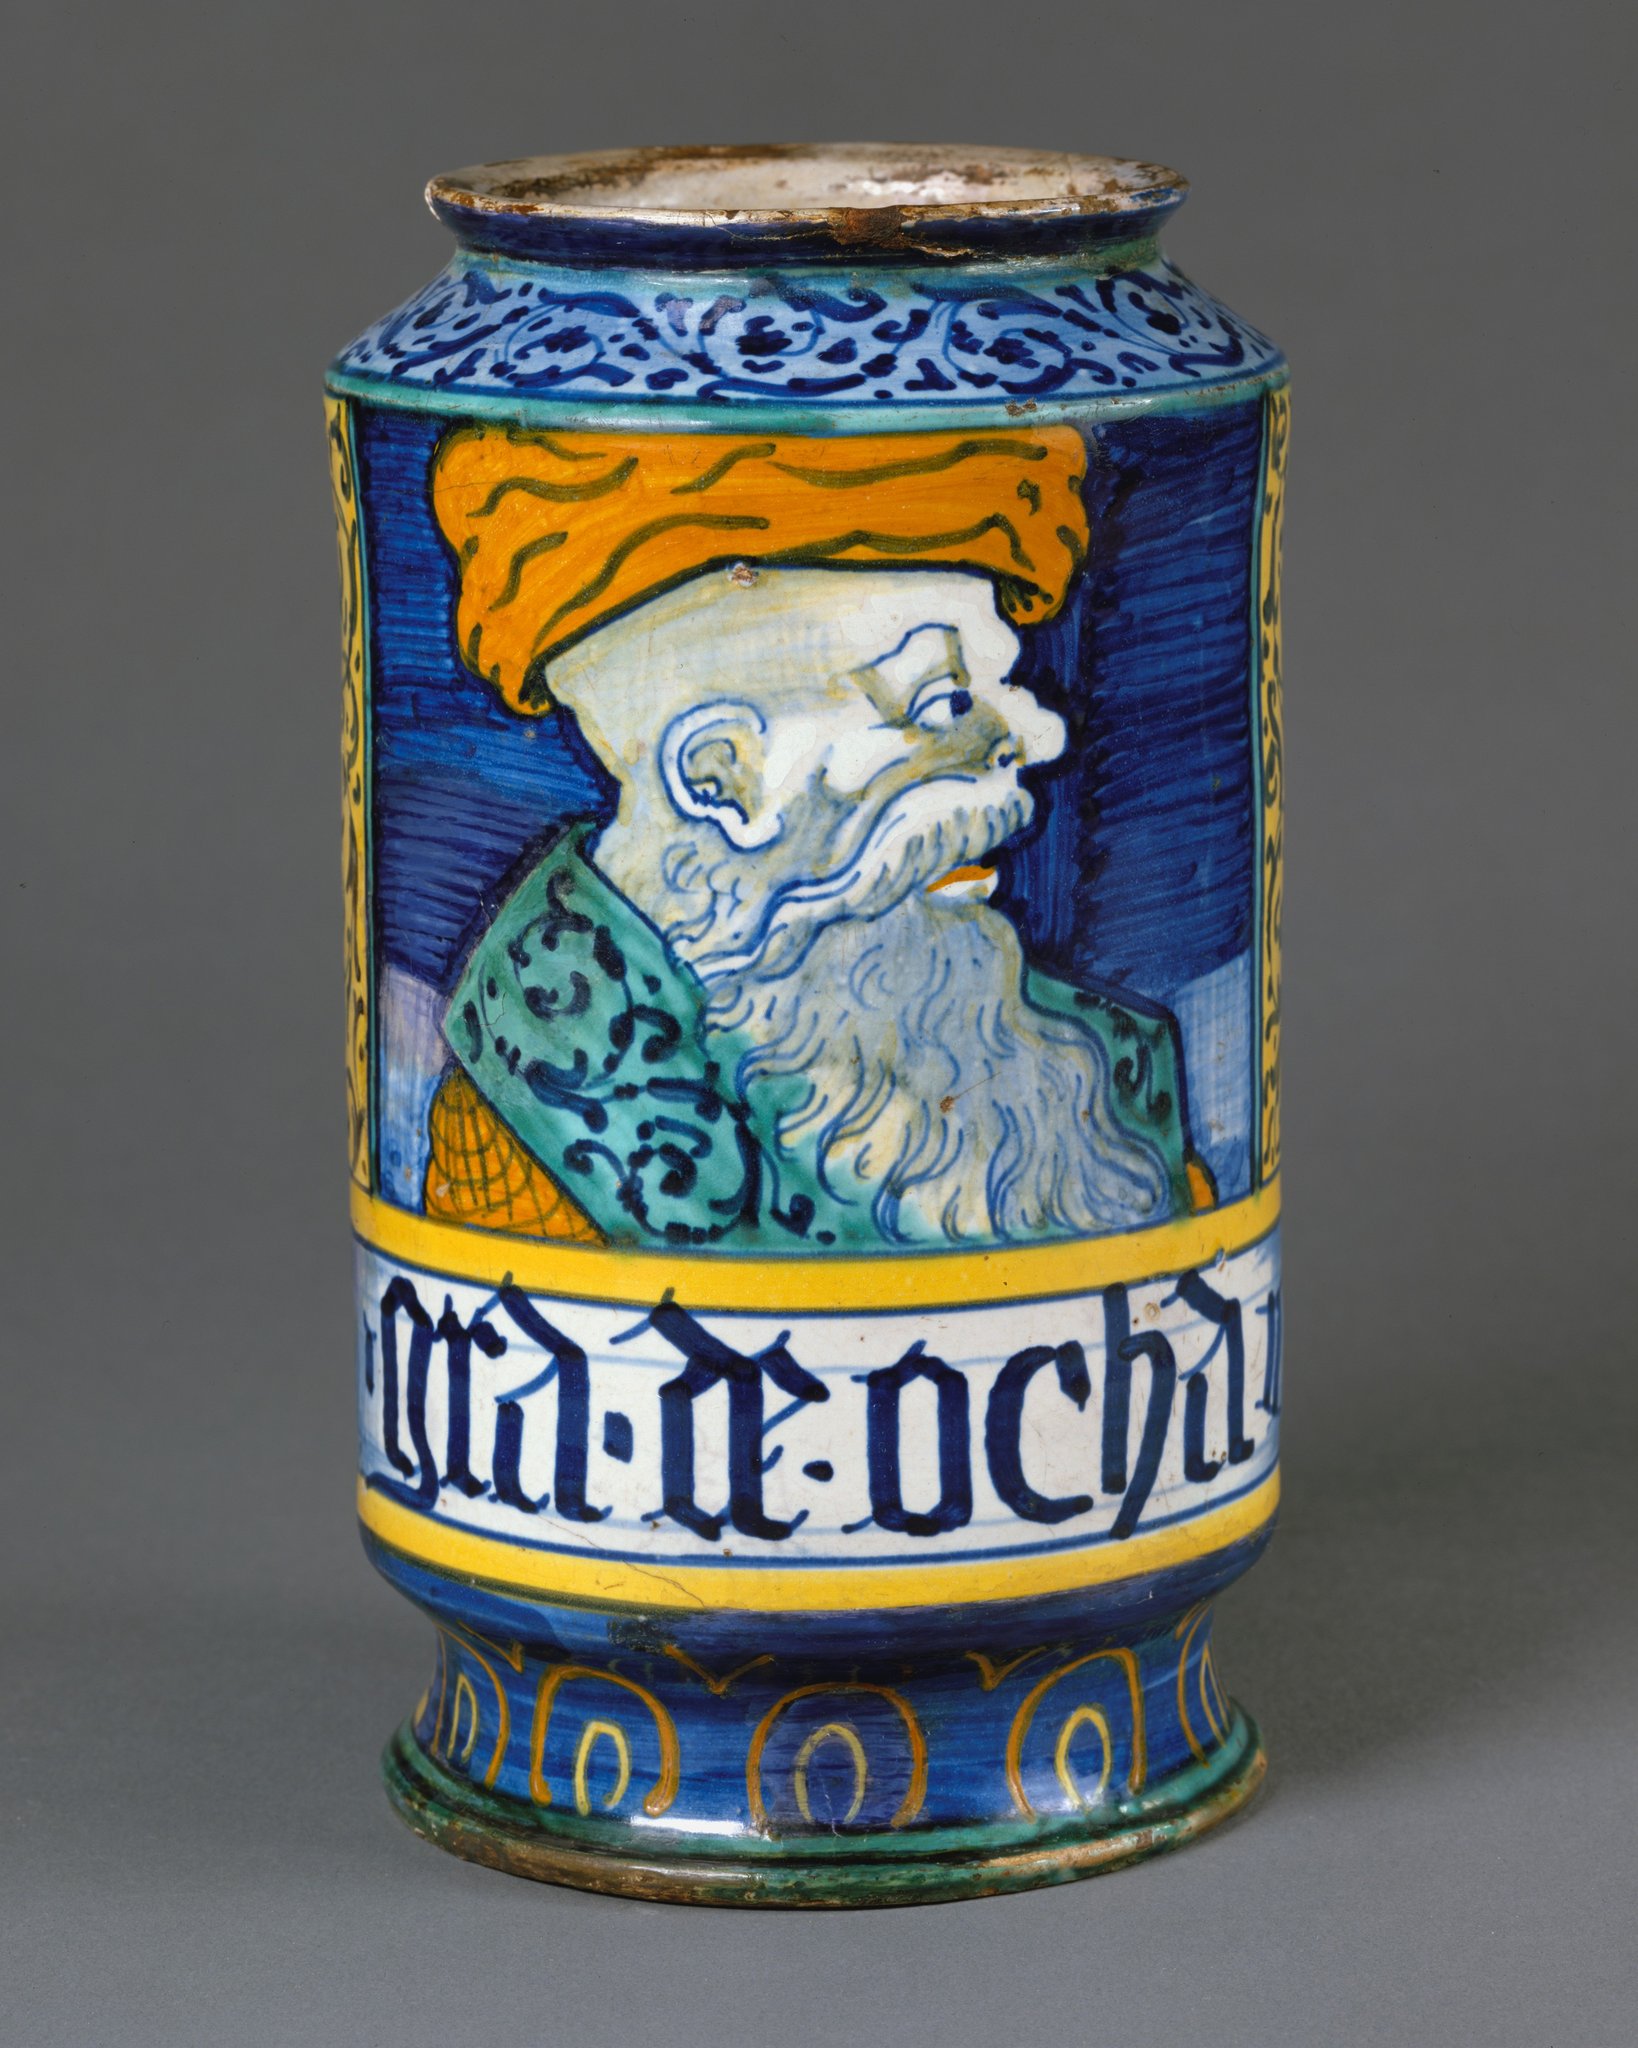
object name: albarello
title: Apothecary jar (albarello)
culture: italian, castelli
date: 1530-1540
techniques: maiolica, glazing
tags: men,profiles